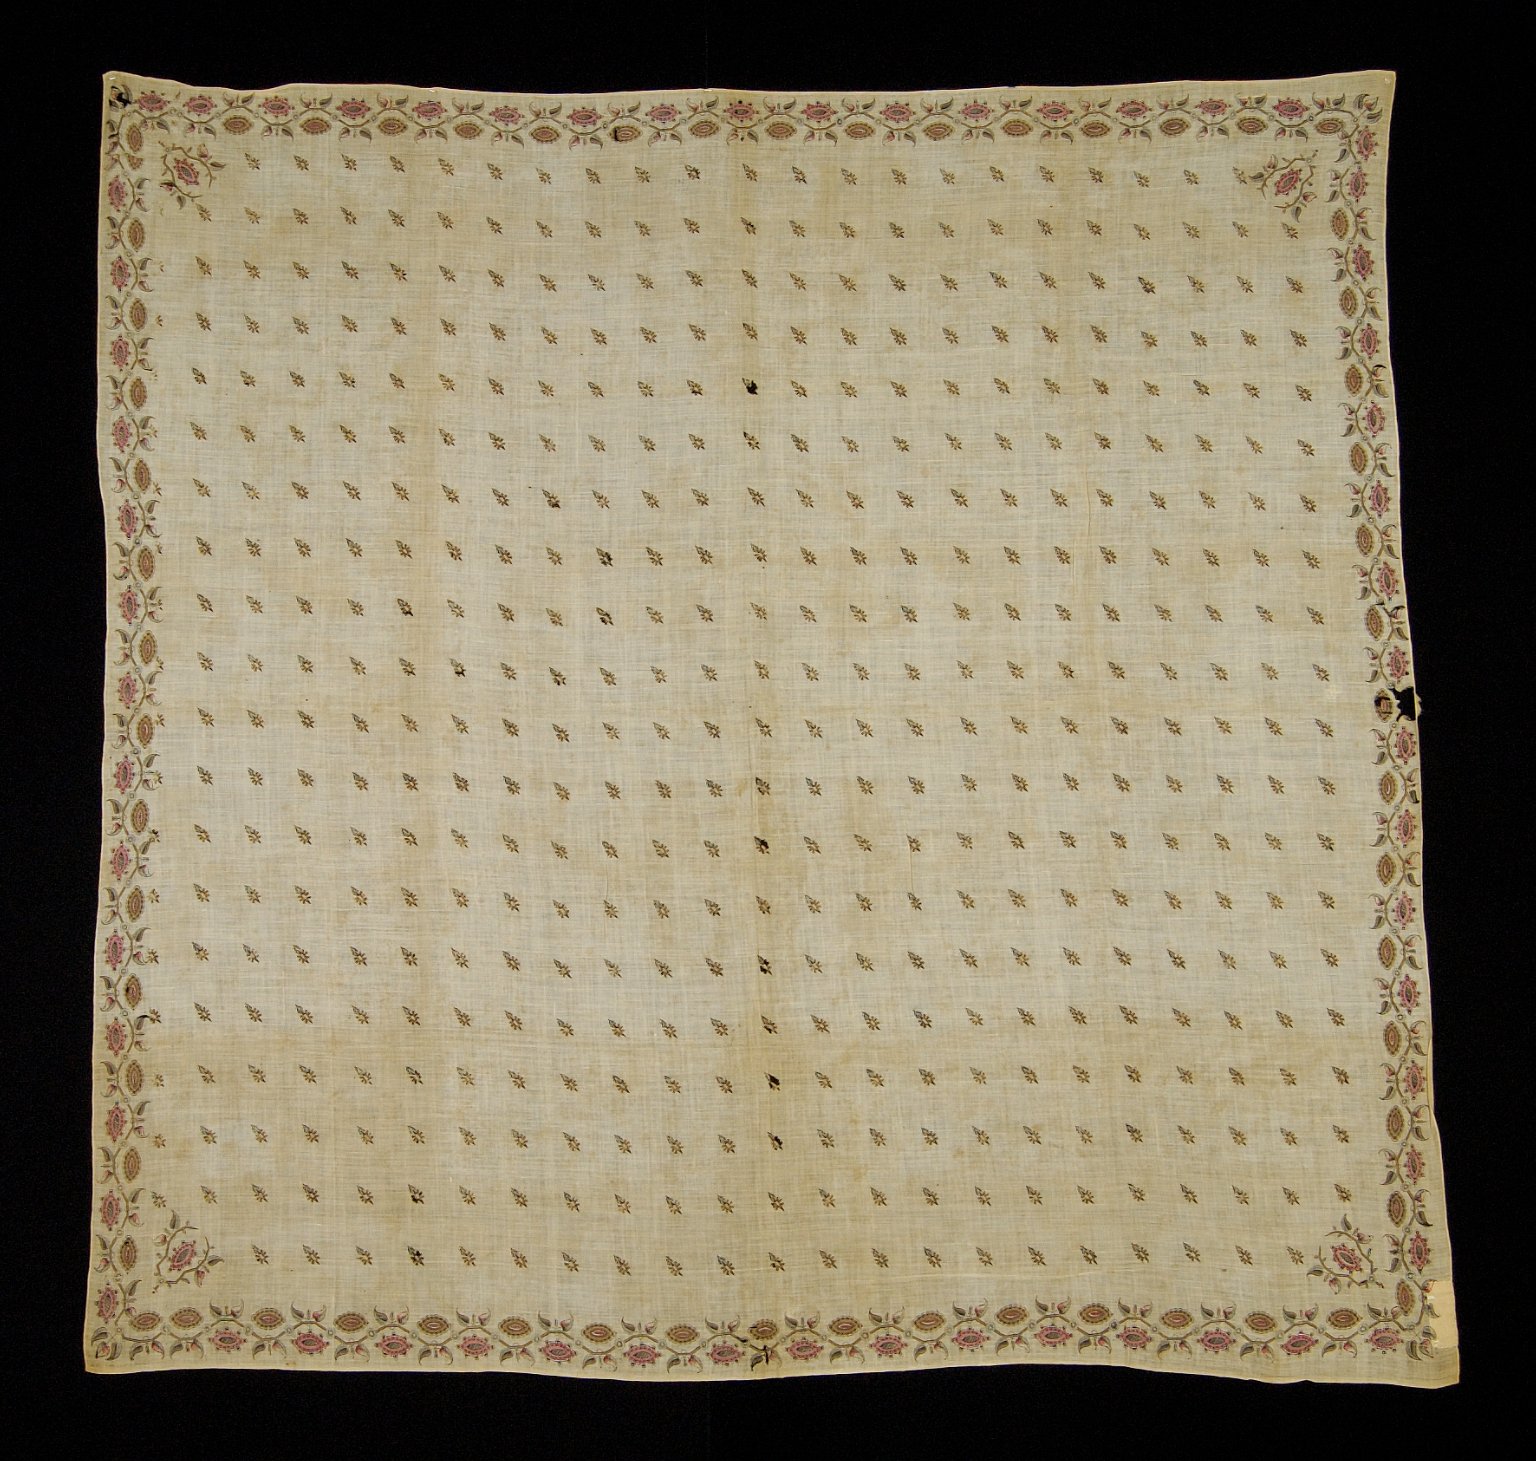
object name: kerchief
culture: american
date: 1790-1810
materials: cotton